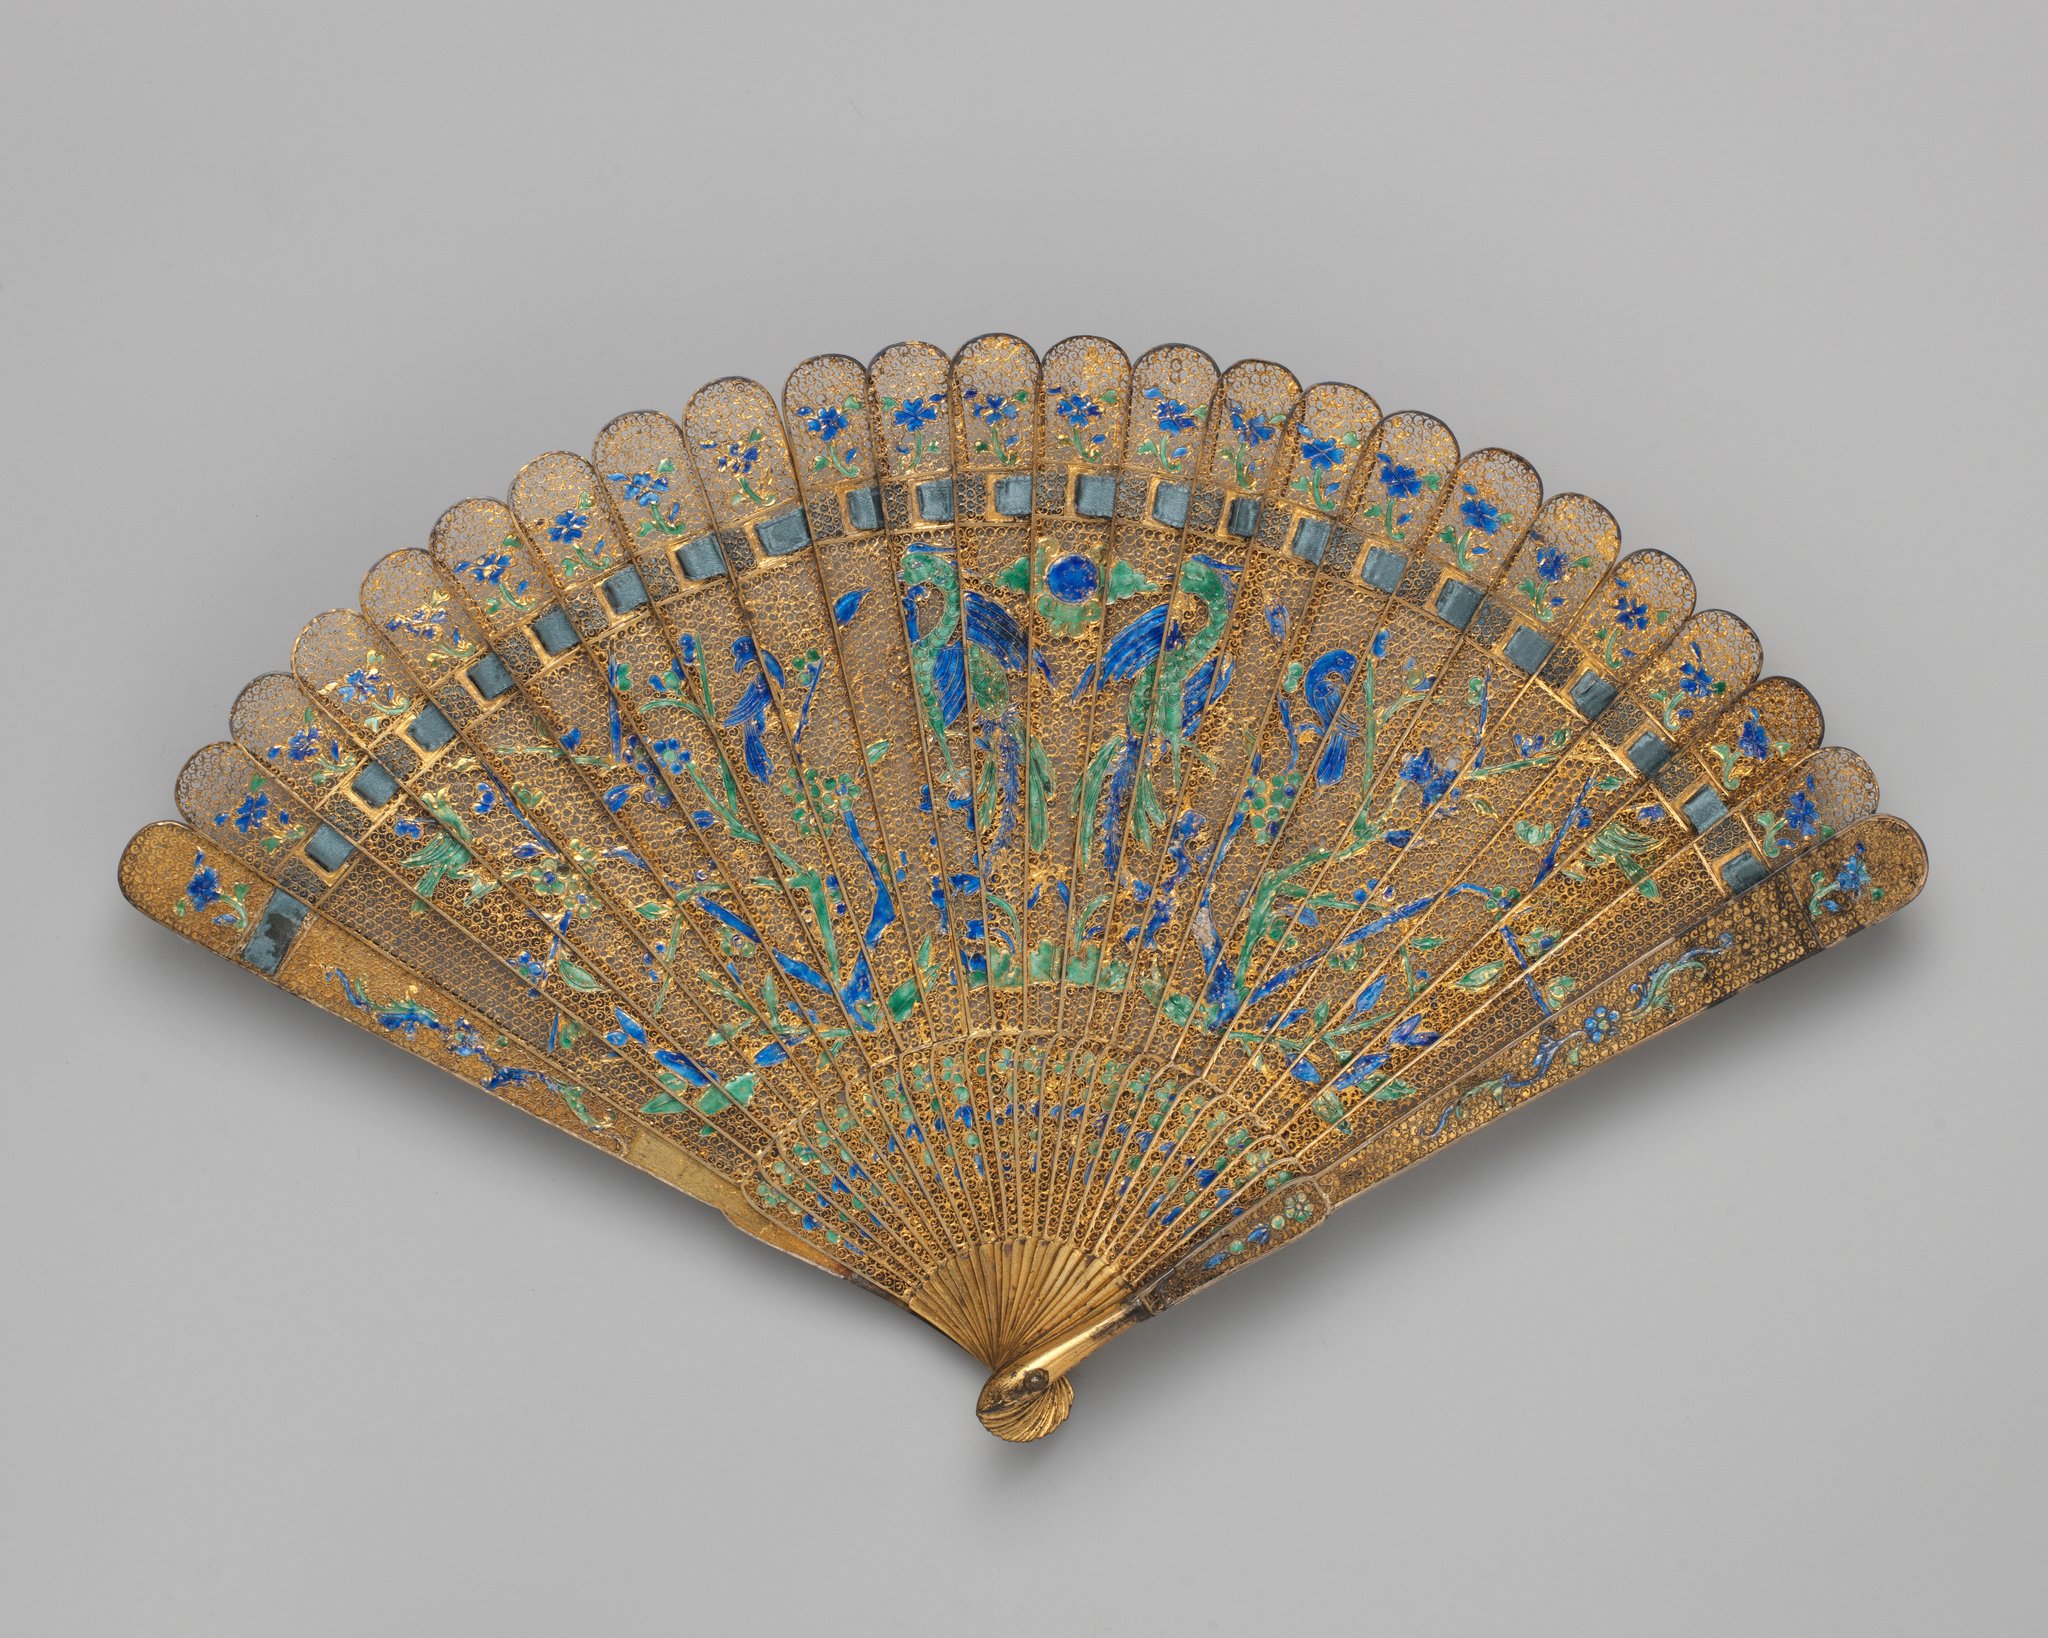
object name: fan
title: Brisé Fan, with representations of birds on branches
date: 1801-1900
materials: enamel, silver gilt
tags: birds